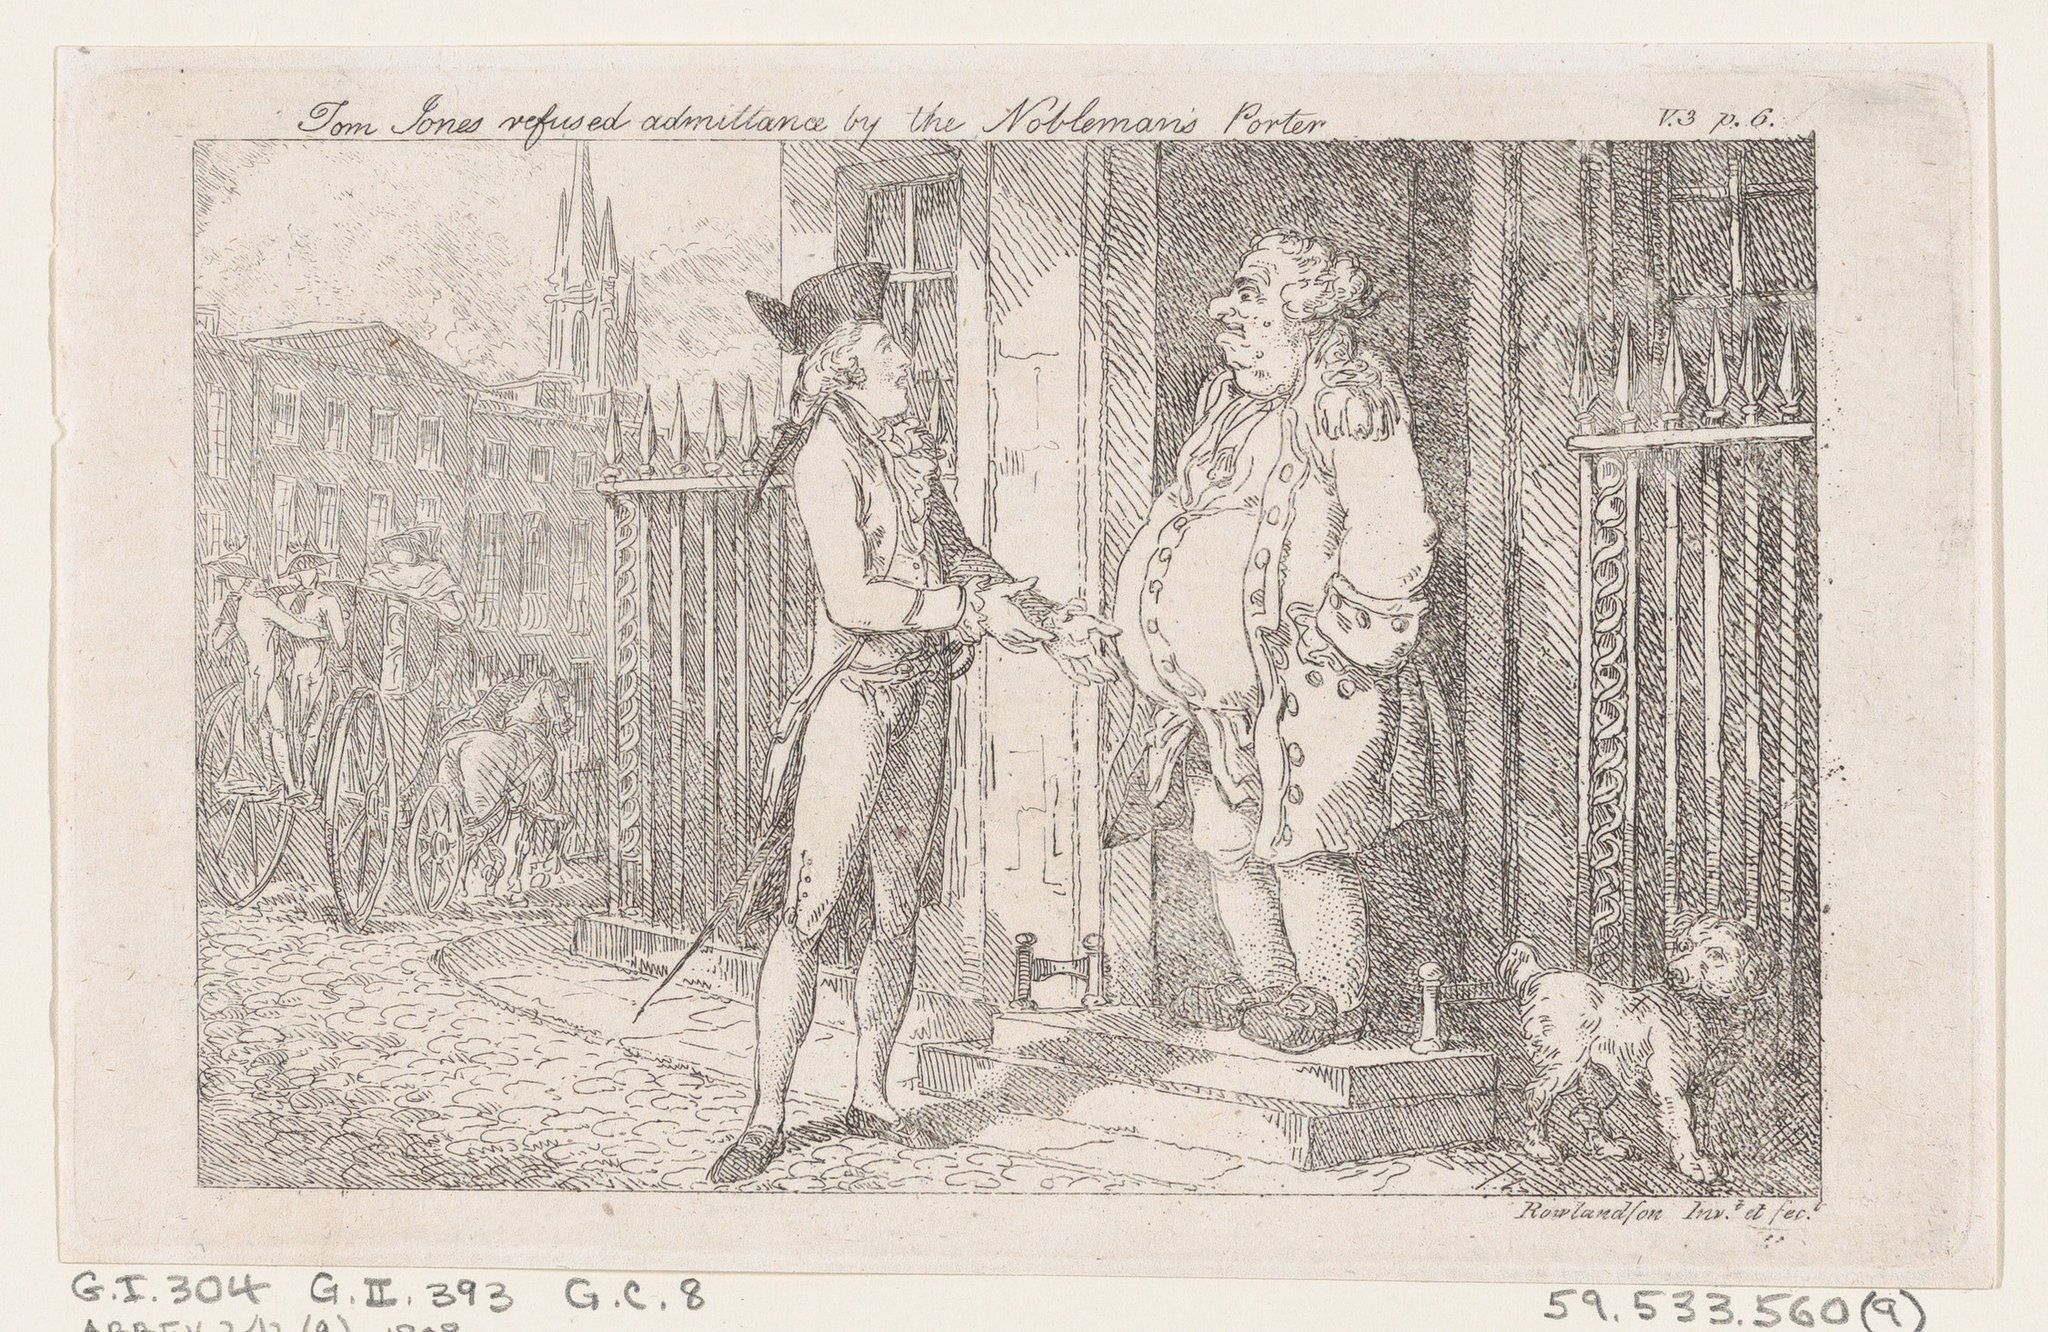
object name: print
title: Tom Jones Refused Admittance by the Nobleman's Porter, from "The History of Tom Jones, a Foundling"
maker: thomas rowlandson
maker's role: artist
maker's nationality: british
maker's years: 1757-1827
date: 1792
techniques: etching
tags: men,dogs,carriages